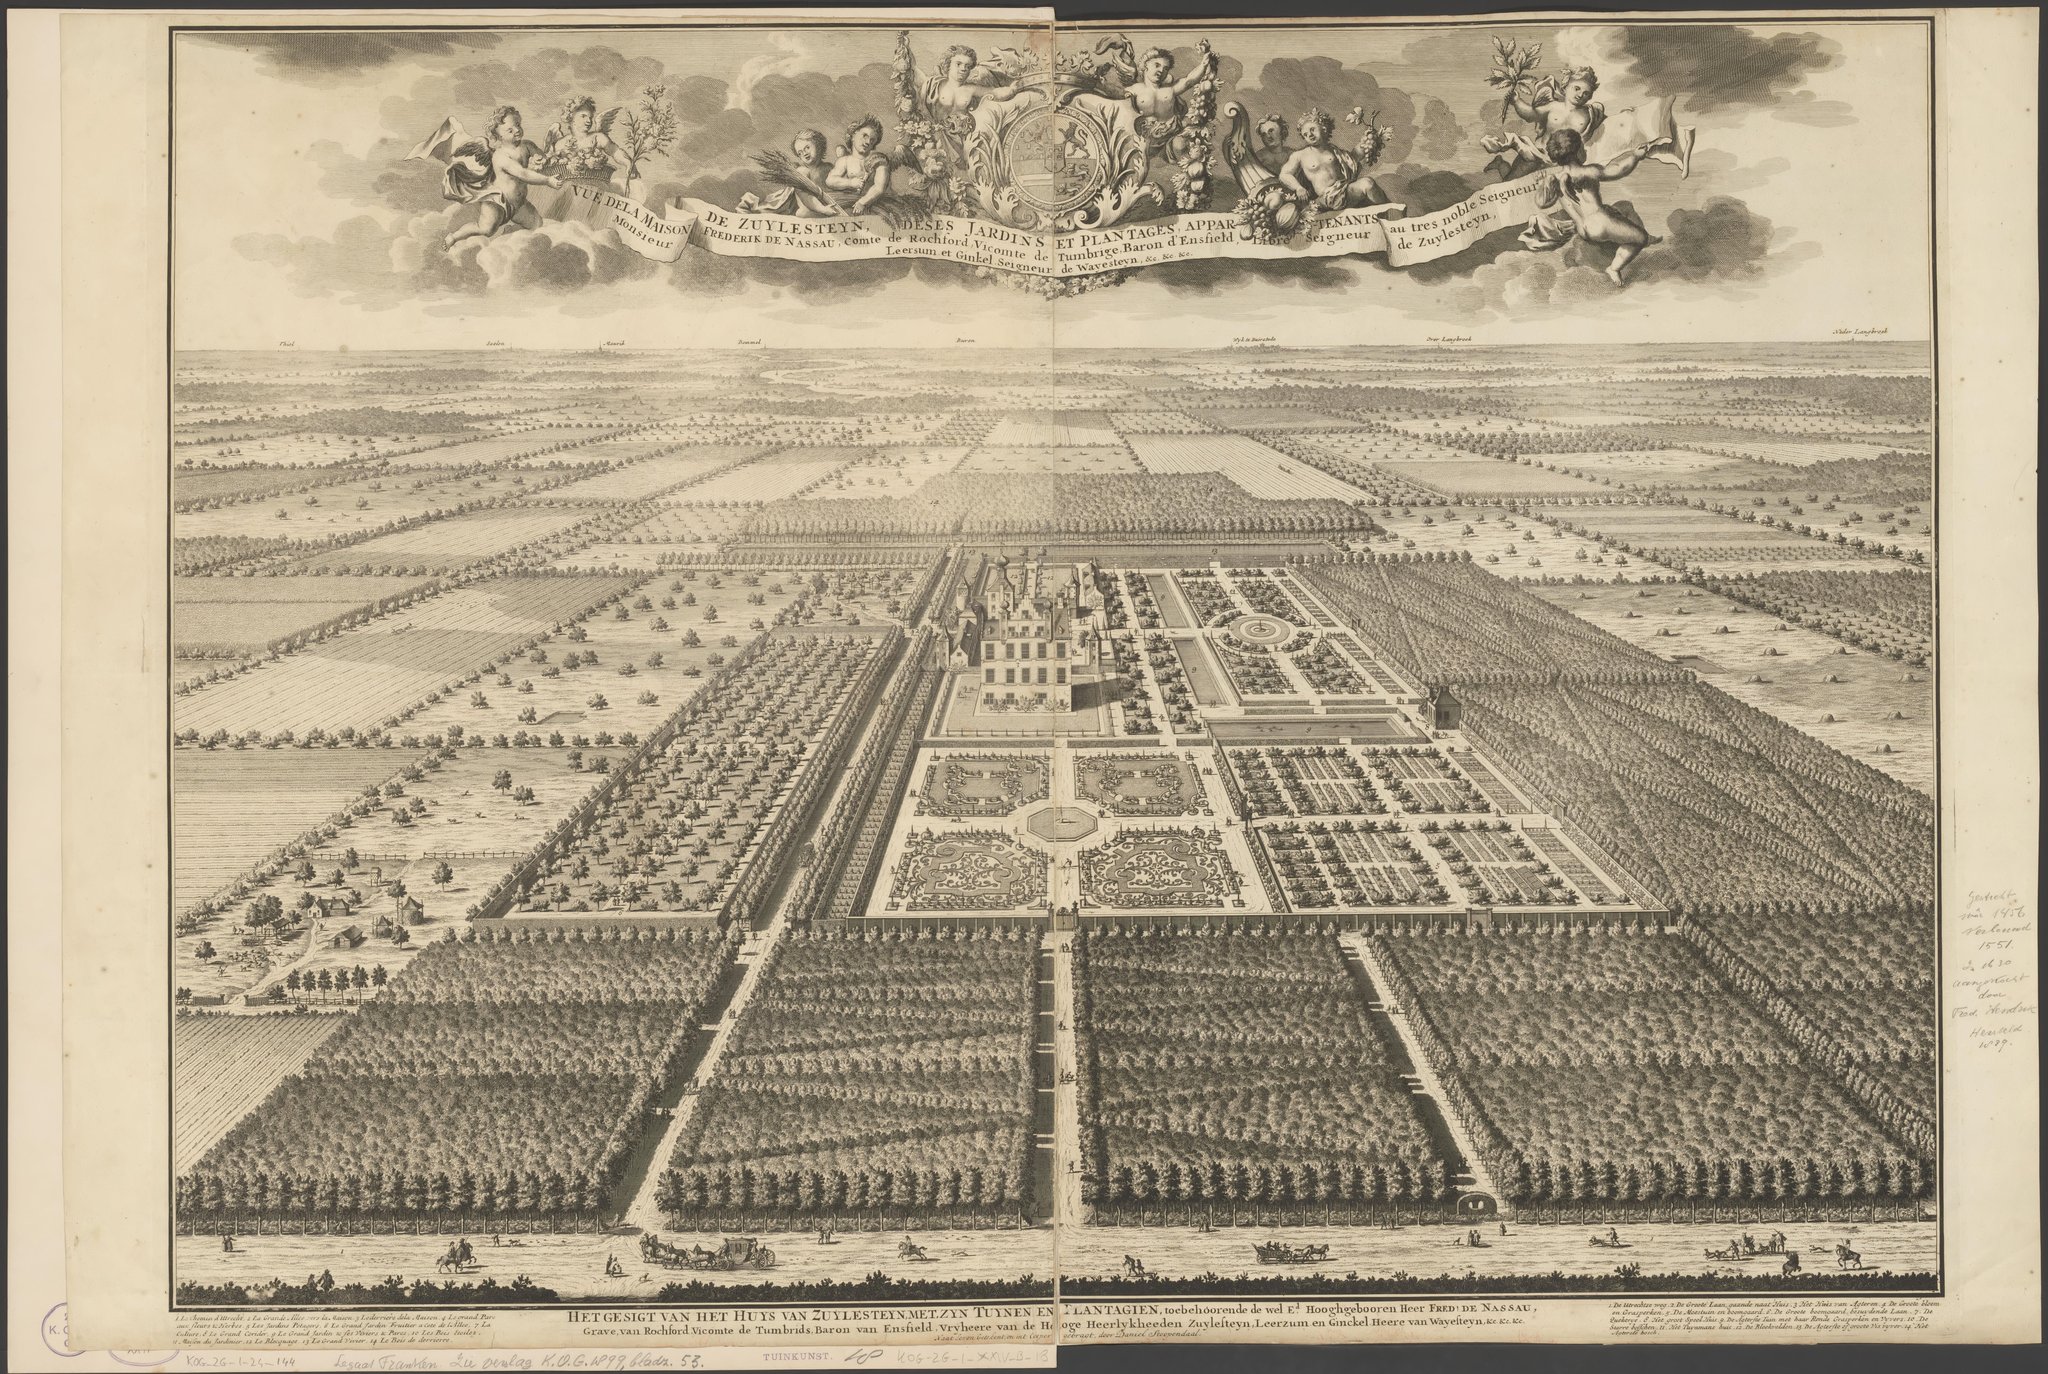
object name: print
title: Veue de la maison de Zuylestein, de ses Jardins et Plantages, appartenants monsieur (...) / Het Gesigt van het Huys van Zuylestein, met zyn tuynen en plantagien, toebehoorende de Wel Ed. Hooghgebooren Heer Fred de Nassau, Grave van Rochford, Vicomte de Tumbrids (...)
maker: daniël stopendaal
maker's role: print maker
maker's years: 1672-1726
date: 1695-1726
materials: paper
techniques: etching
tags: bird's eye view ~ representation of building, country-house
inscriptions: collector's mark: Lugt 1641, collector's mark: Lugt 963, stamp:, collector's mark: Lugt 1641, stamp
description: Gezicht op Kasteel Zuilenstein te Leersum met de tuinen en de omgeving in vogelvlucht. Op de achtergrond in het landschap Tiel, Wijk bij Duurstede en Langbroek. In de lucht tonen putti een banderol en het wapenschild van Frederik van Nassau. De titels op de banderol behoren toe aan zijn zoon Willem Hendrik van Nassau-Zuylestein. Onderaan in de marge een legenda in het Frans en in het Nederlands. Onderwerpsrubrieken binnen de Atlas Zeden en Gewoonten: Zeden en Gewoonten in Engeren Zin, De Woning, Oude Nederlandsche Tuinkunst. De kasteeltuin.